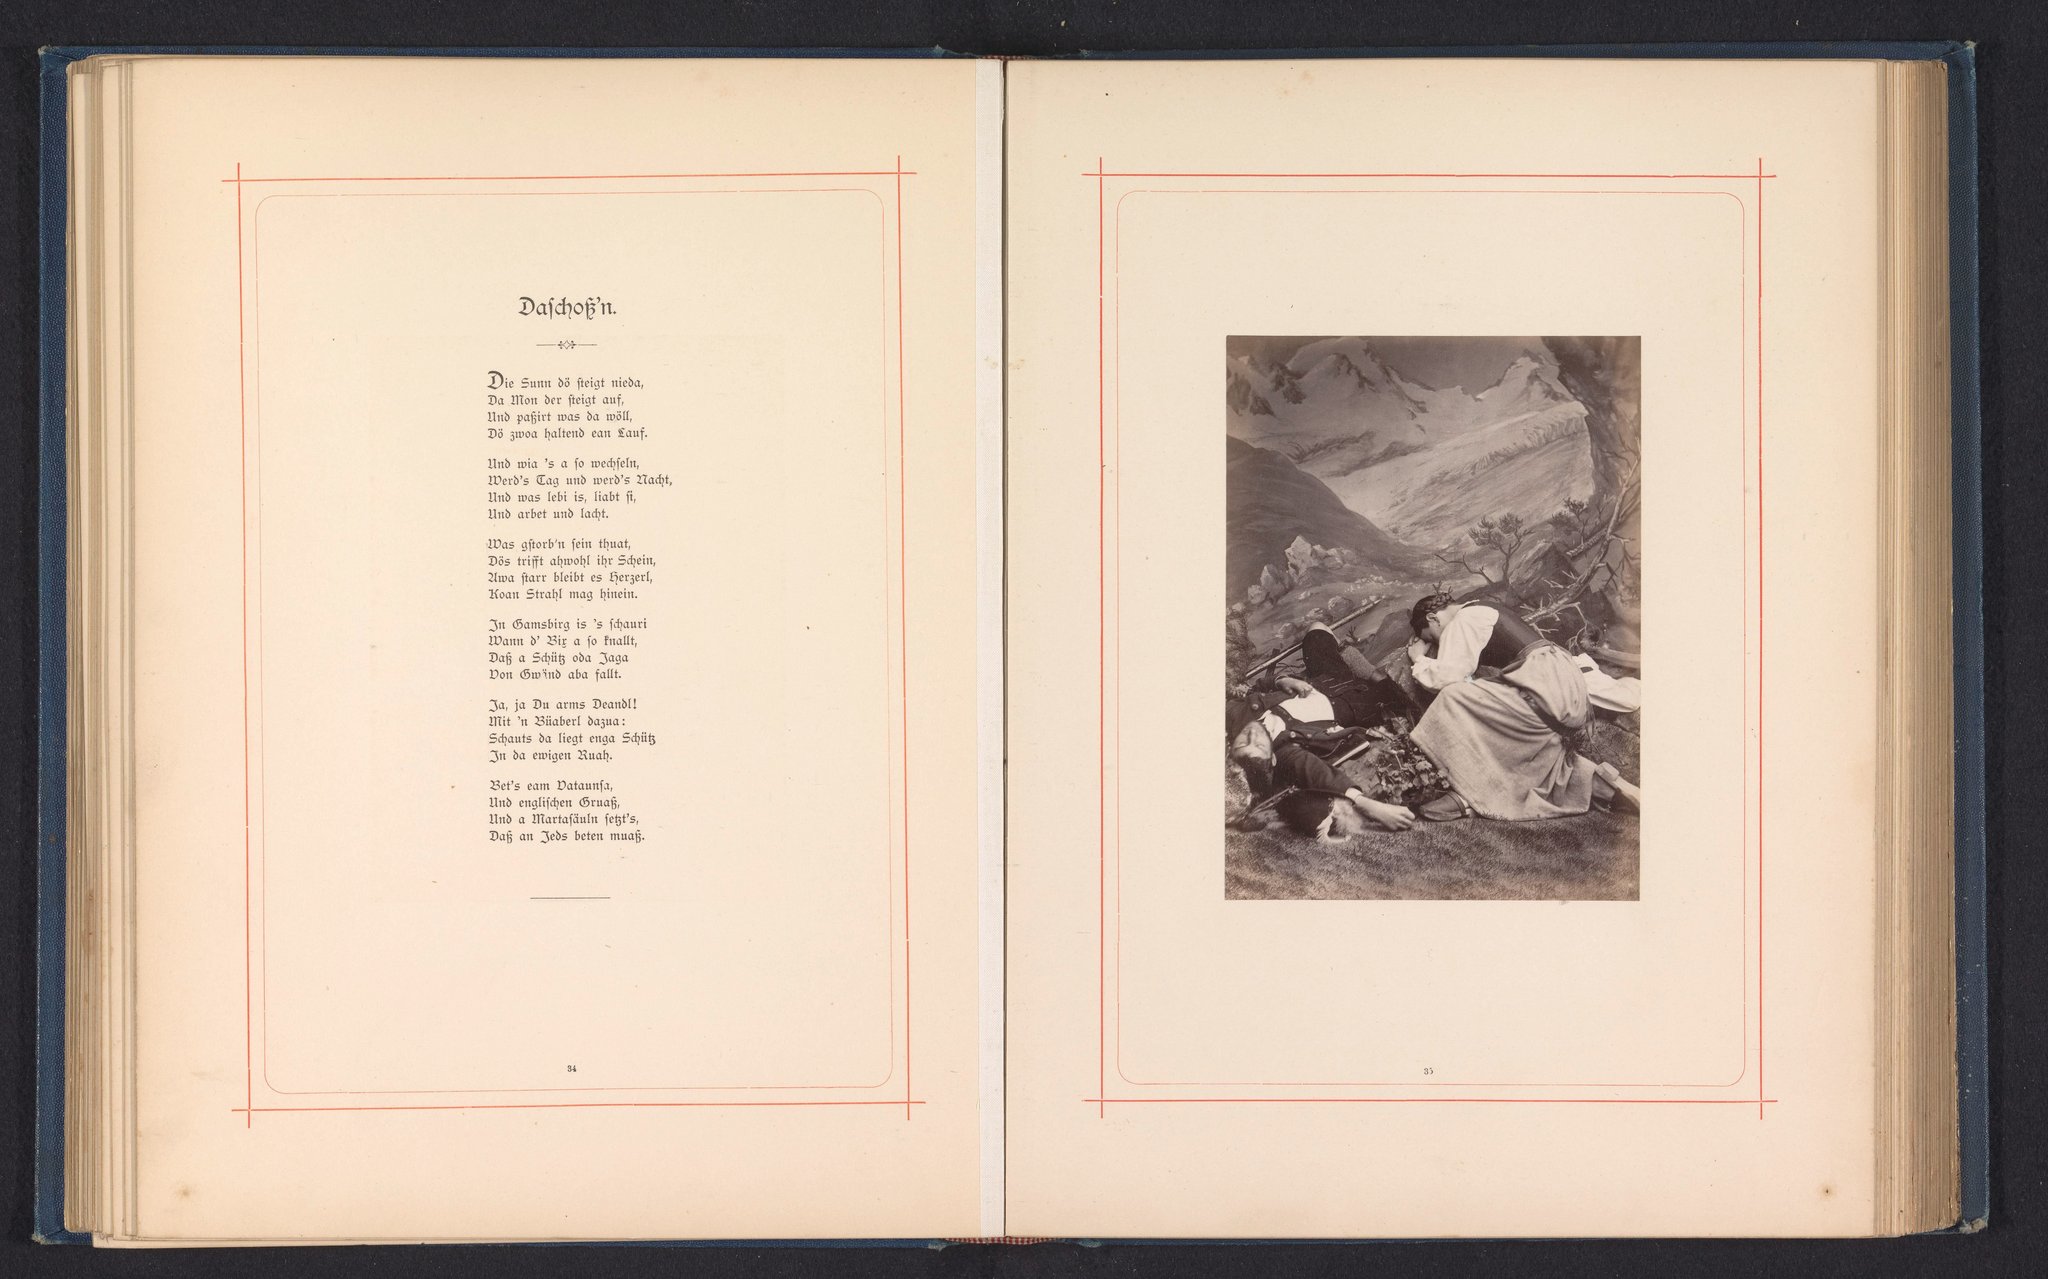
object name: photograph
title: Vrouw in klederdracht beweent een omgekomen man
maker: max balde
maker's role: fotograaf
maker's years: 1844-1900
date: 1877-1882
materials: photographic support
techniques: albumen print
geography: salzburg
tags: adult woman, mourning customs, folk costume, regional costume, the corpse